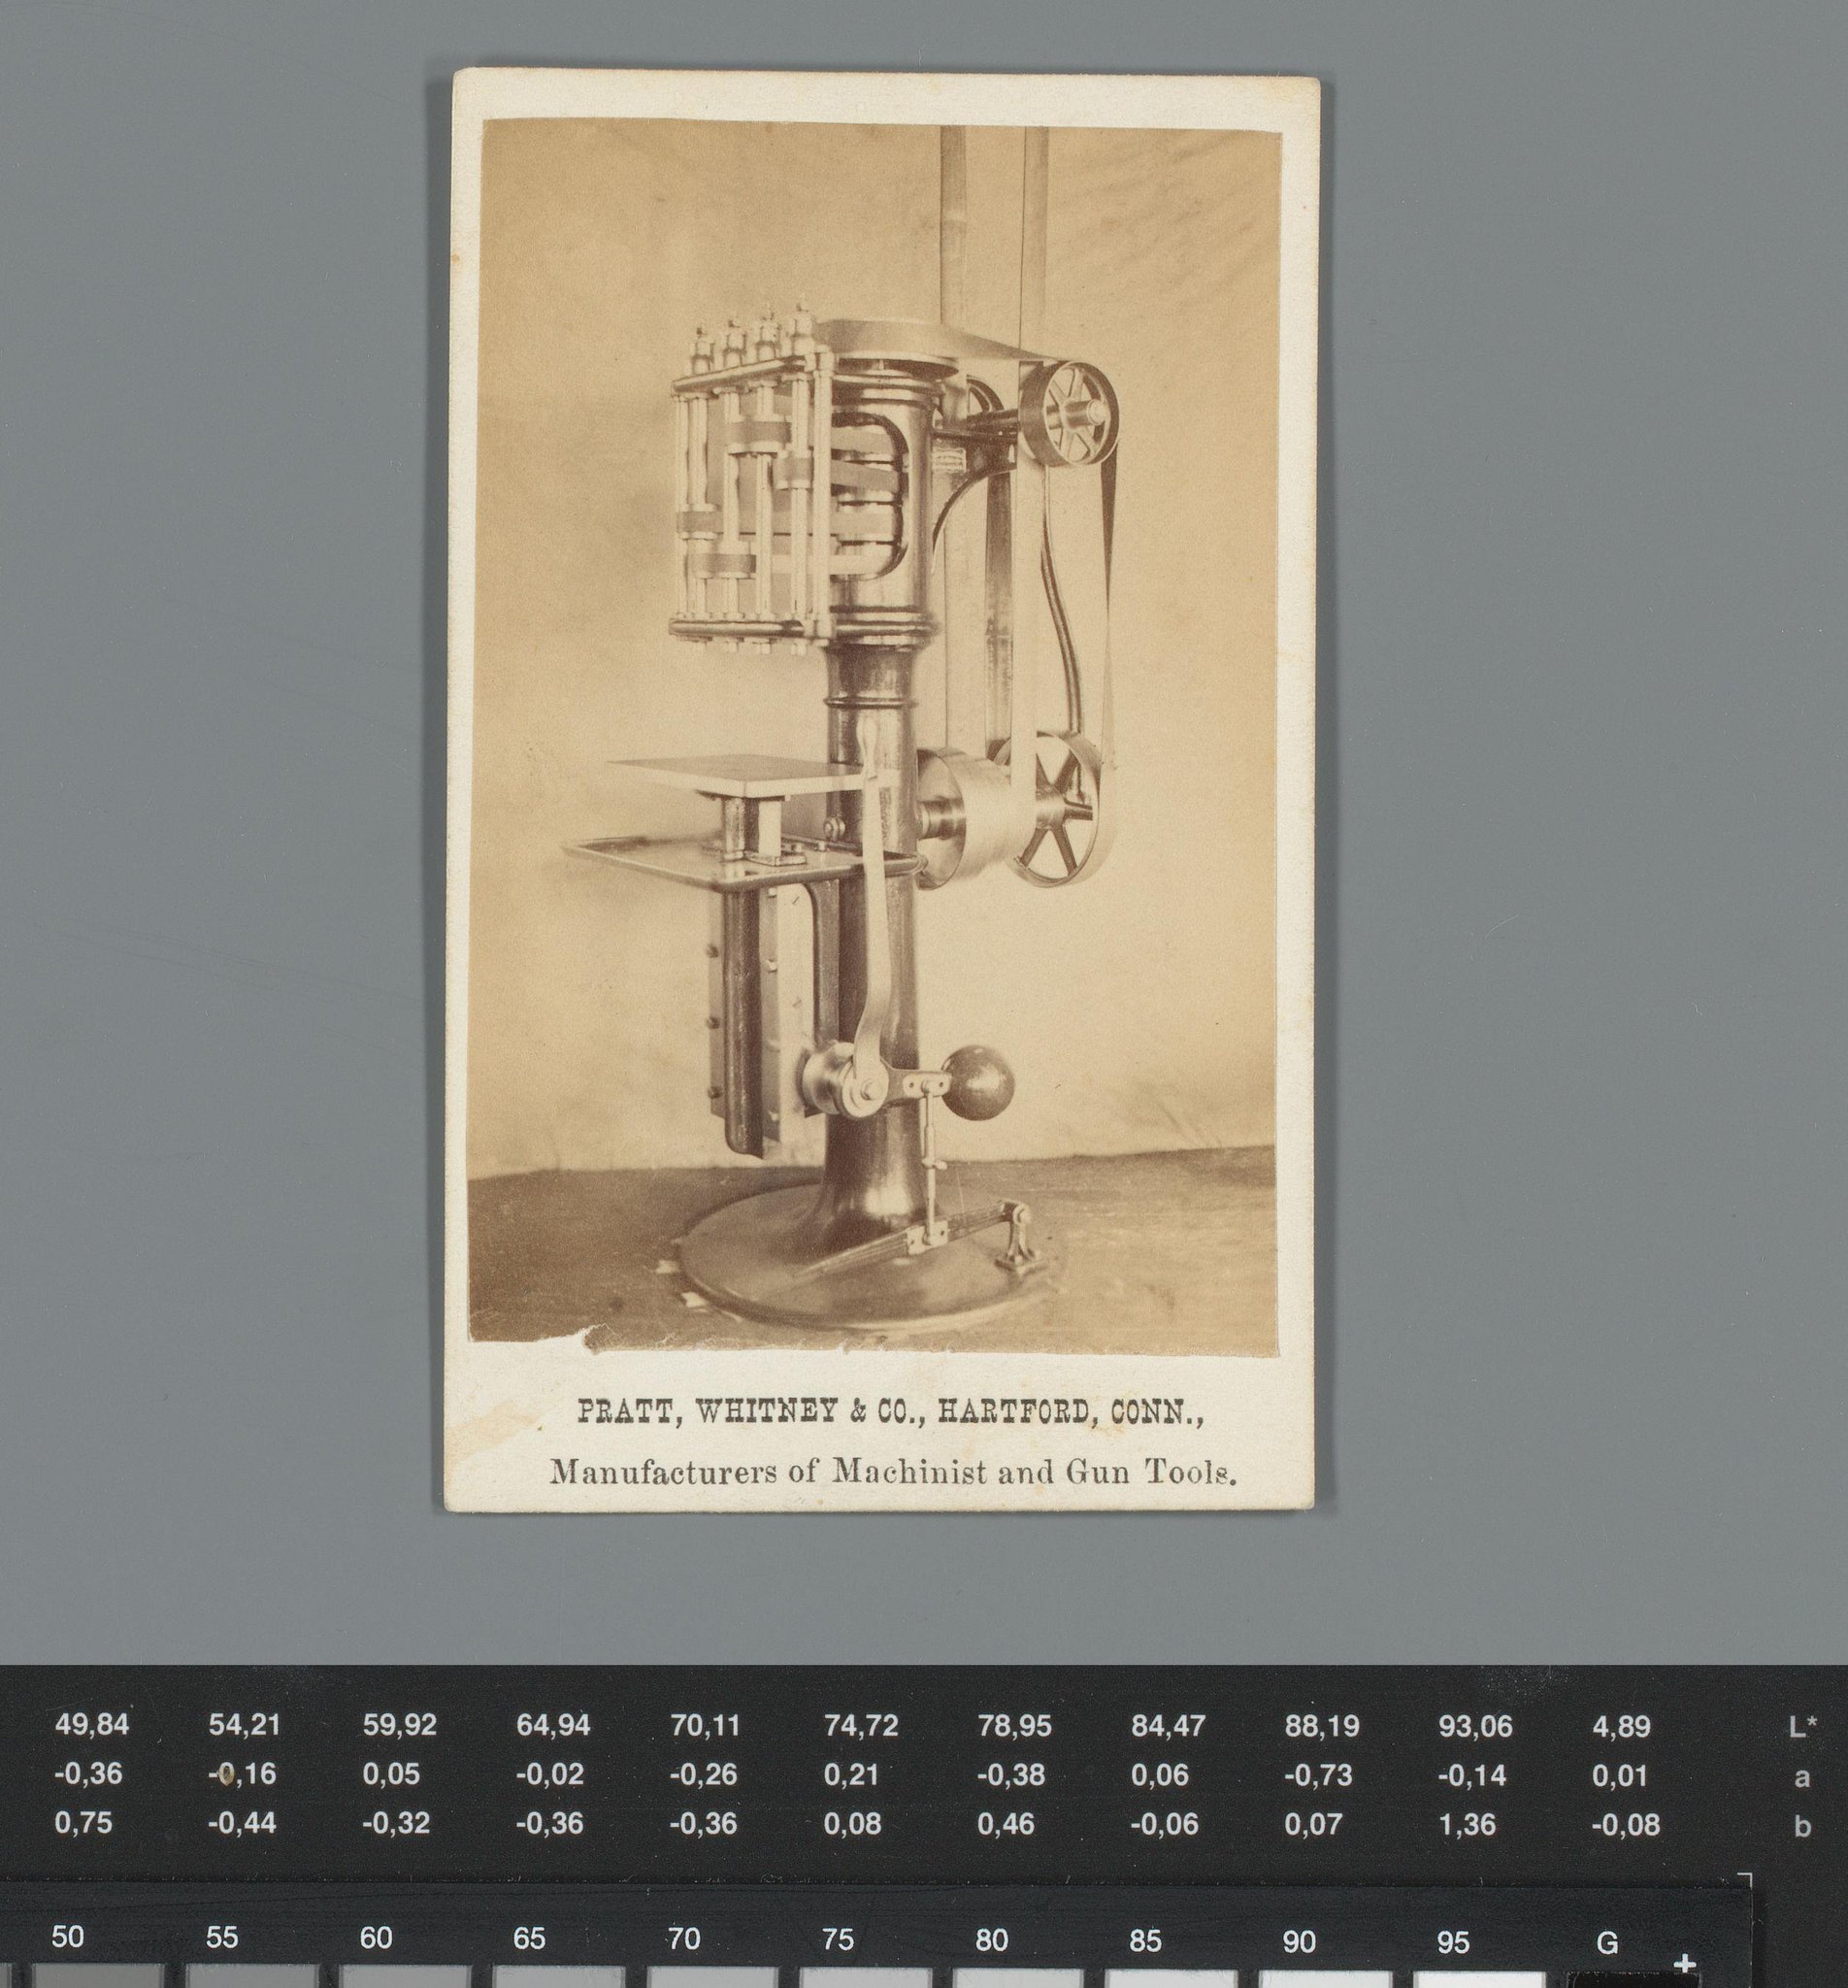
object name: carte de visite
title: Reclame voor een boormachine van Pratt, Whitney & Company in Hartford, Connecticut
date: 1850-1915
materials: cardboard, photographic support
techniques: albumen print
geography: hartford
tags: advertising, machines, engines ~ crafts and industries, tools, aids, implements ~ crafts and industries: drill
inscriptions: inscription: ‘Four Spindle/ Upright Drill’, inscription: ‘(...)/ Prescott & White,/ No. 368 Main Street,/ Hartford, Conn../ (...)’